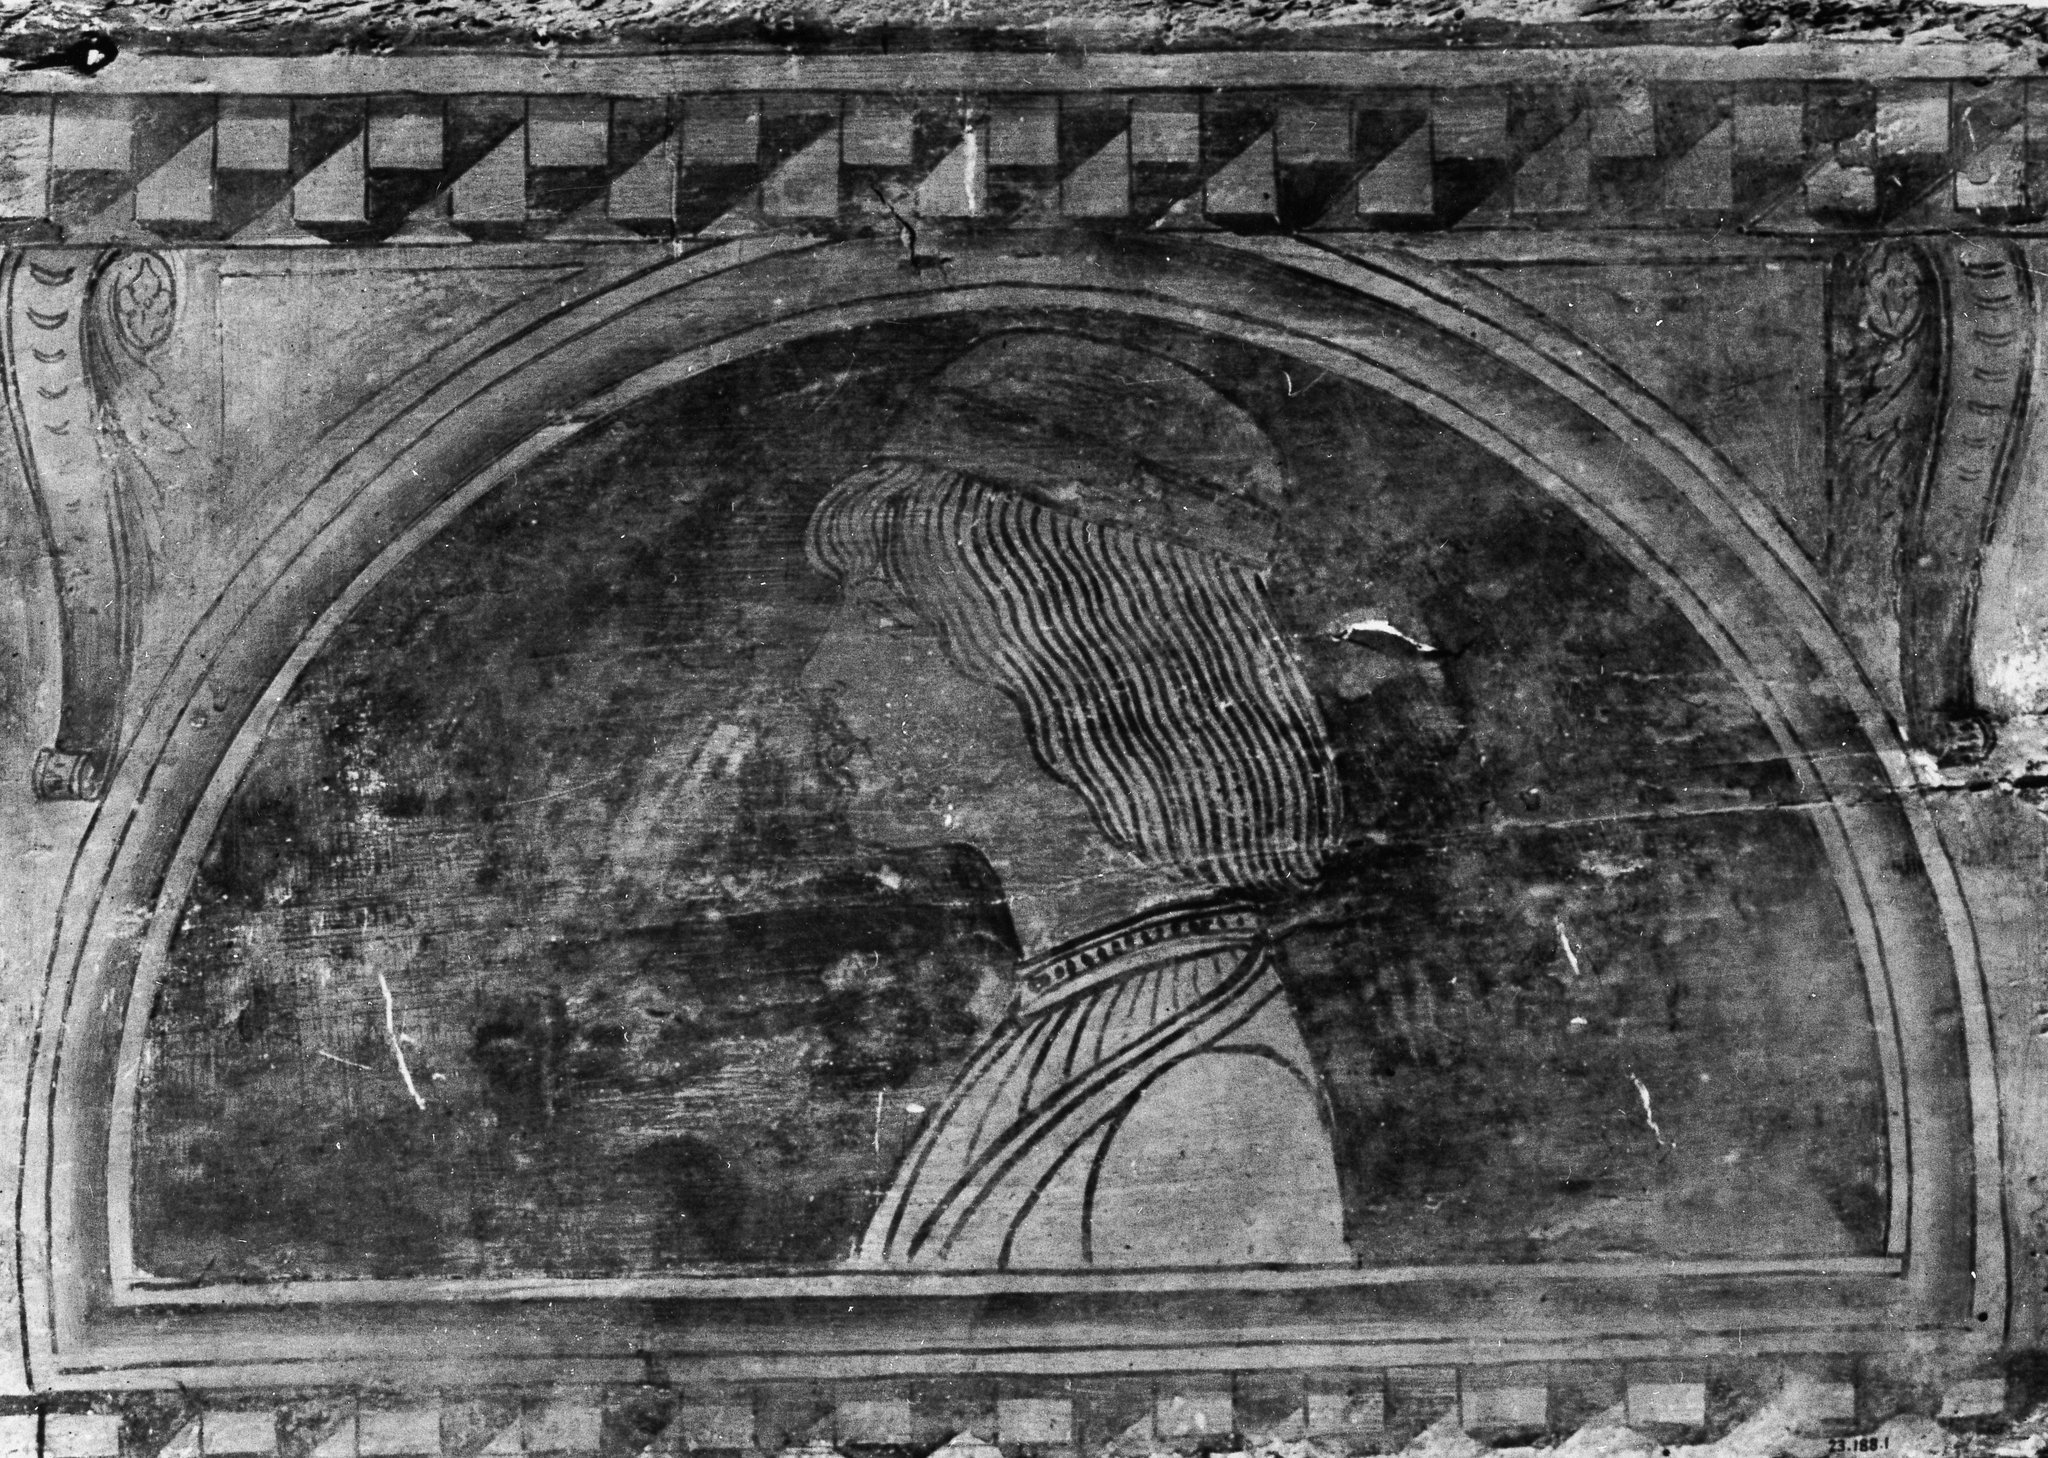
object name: frieze panel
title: Head of a youth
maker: north italian painter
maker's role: artist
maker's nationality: italian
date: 1467-1500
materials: paint, wood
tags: heads,men,profiles